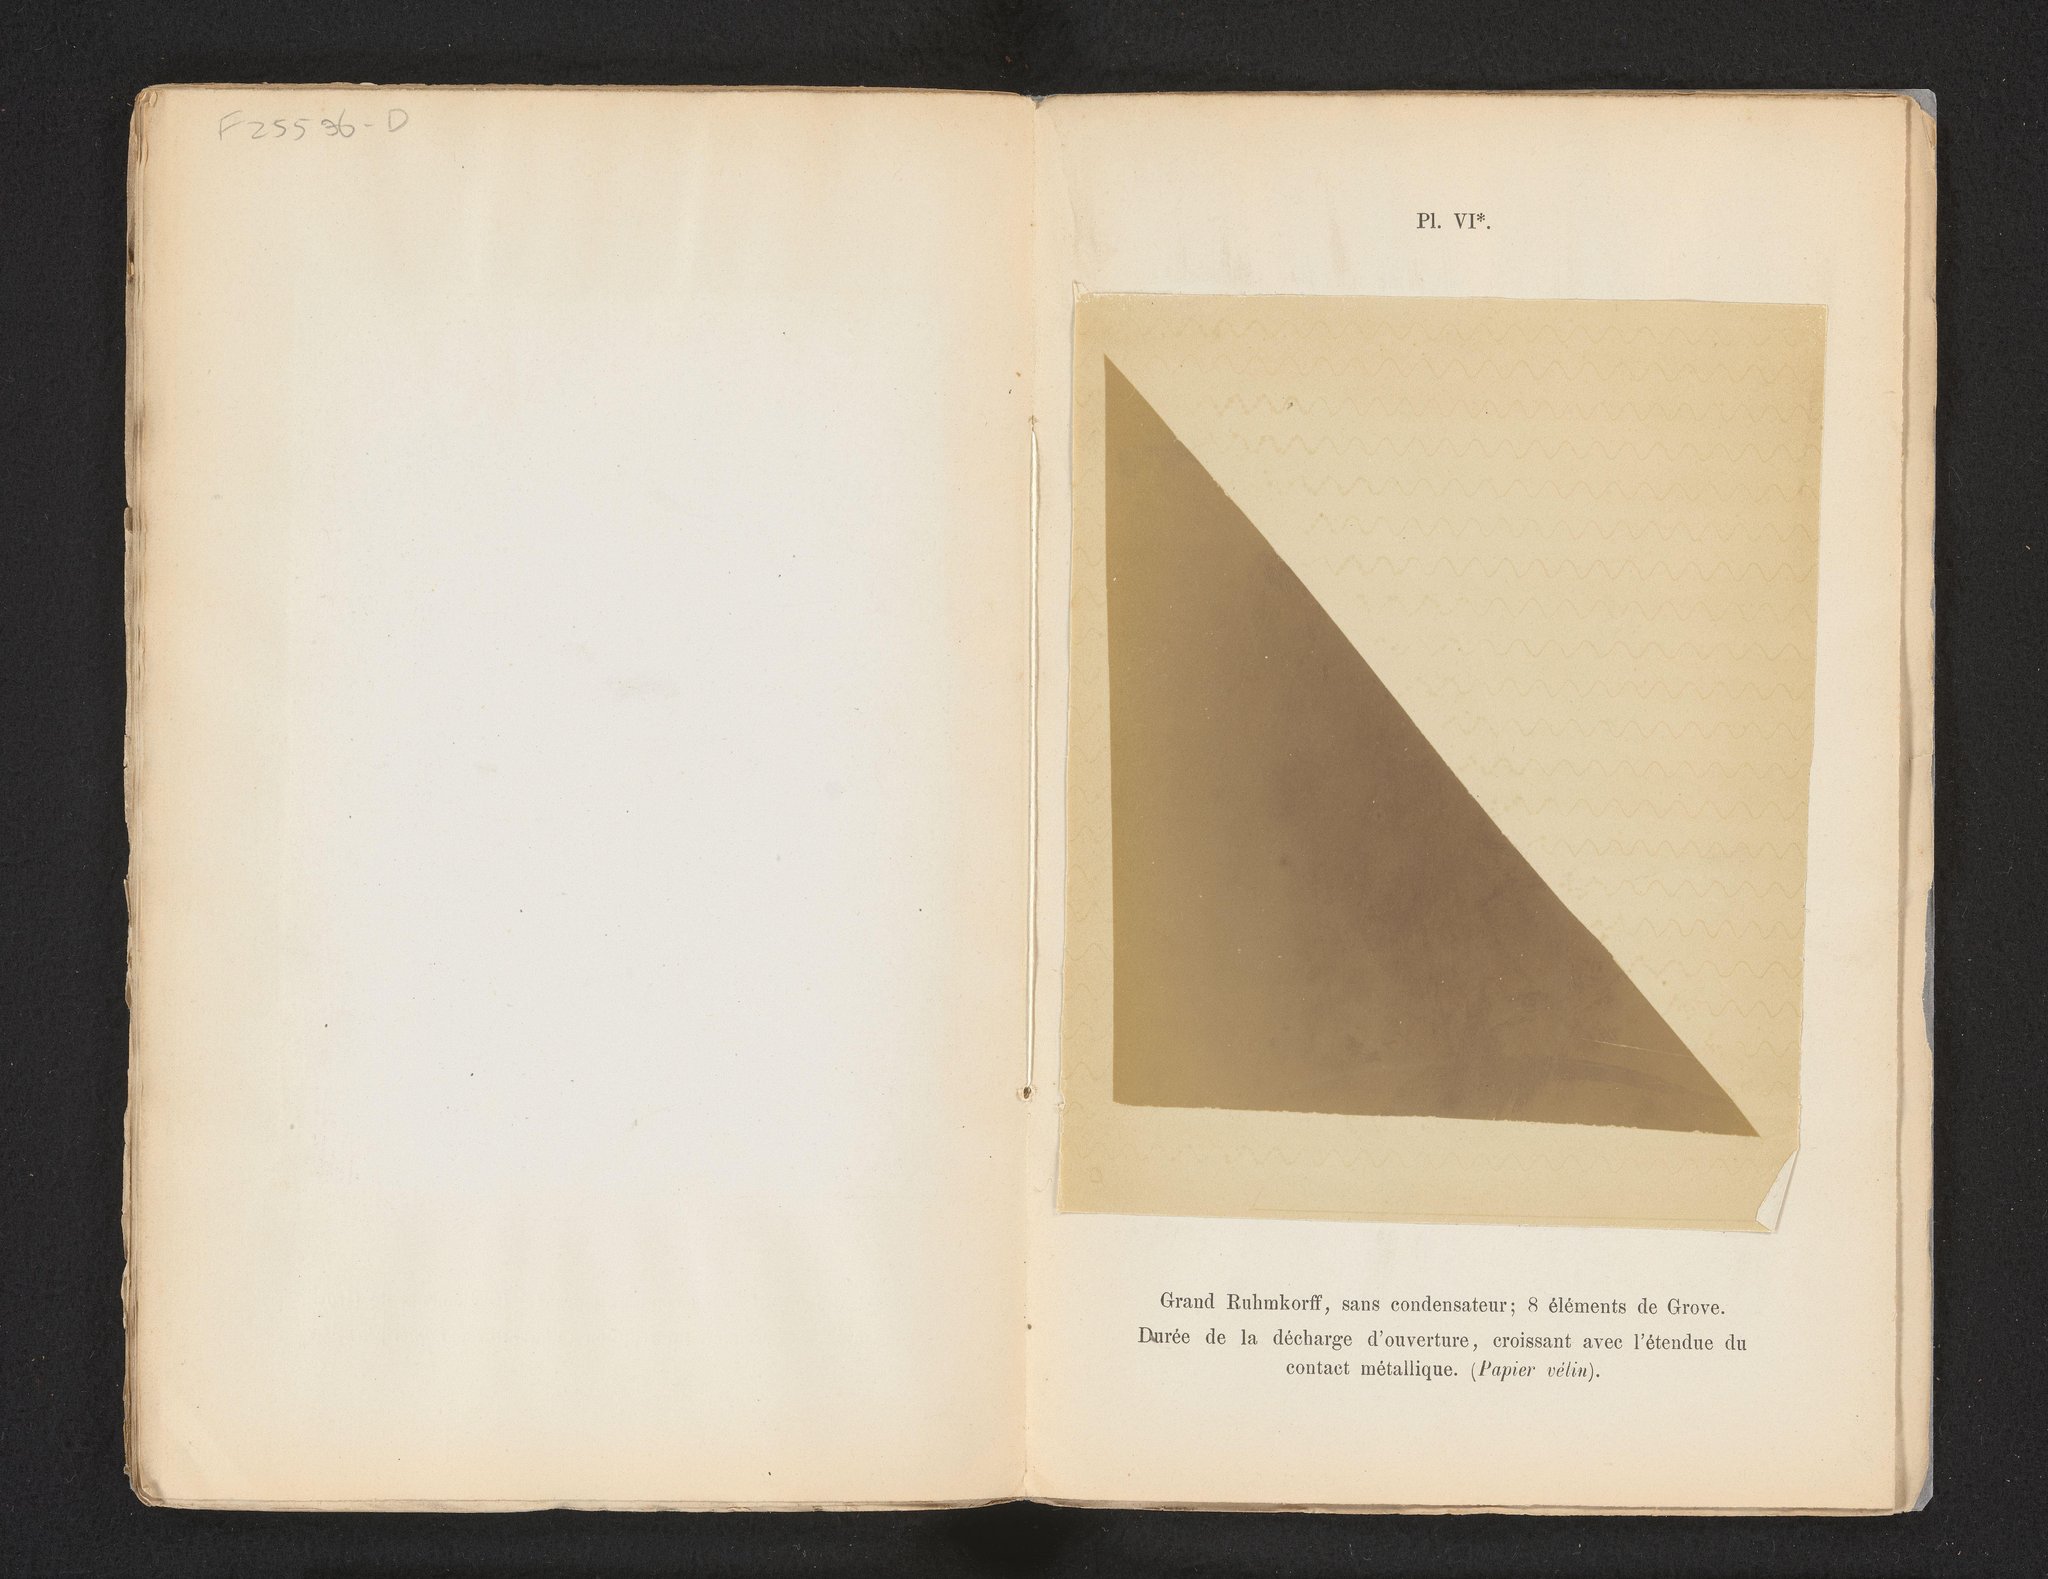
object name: photograph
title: Registratie van electriciteitsgolven opgewekt door een vonkinductor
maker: willem cornelis van dijk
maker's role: painter, print maker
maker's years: 1826-1881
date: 1865-1870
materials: paper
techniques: albumen print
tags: electrical phenomena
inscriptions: inscription: ‘Durée de la décharge d'ouverture, croissant avant l'étendue du contact métallique. (Papier vélin).’, number: ‘Pl. VI*.’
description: Foto op elfde ongenummerde pagina na pagina 368.